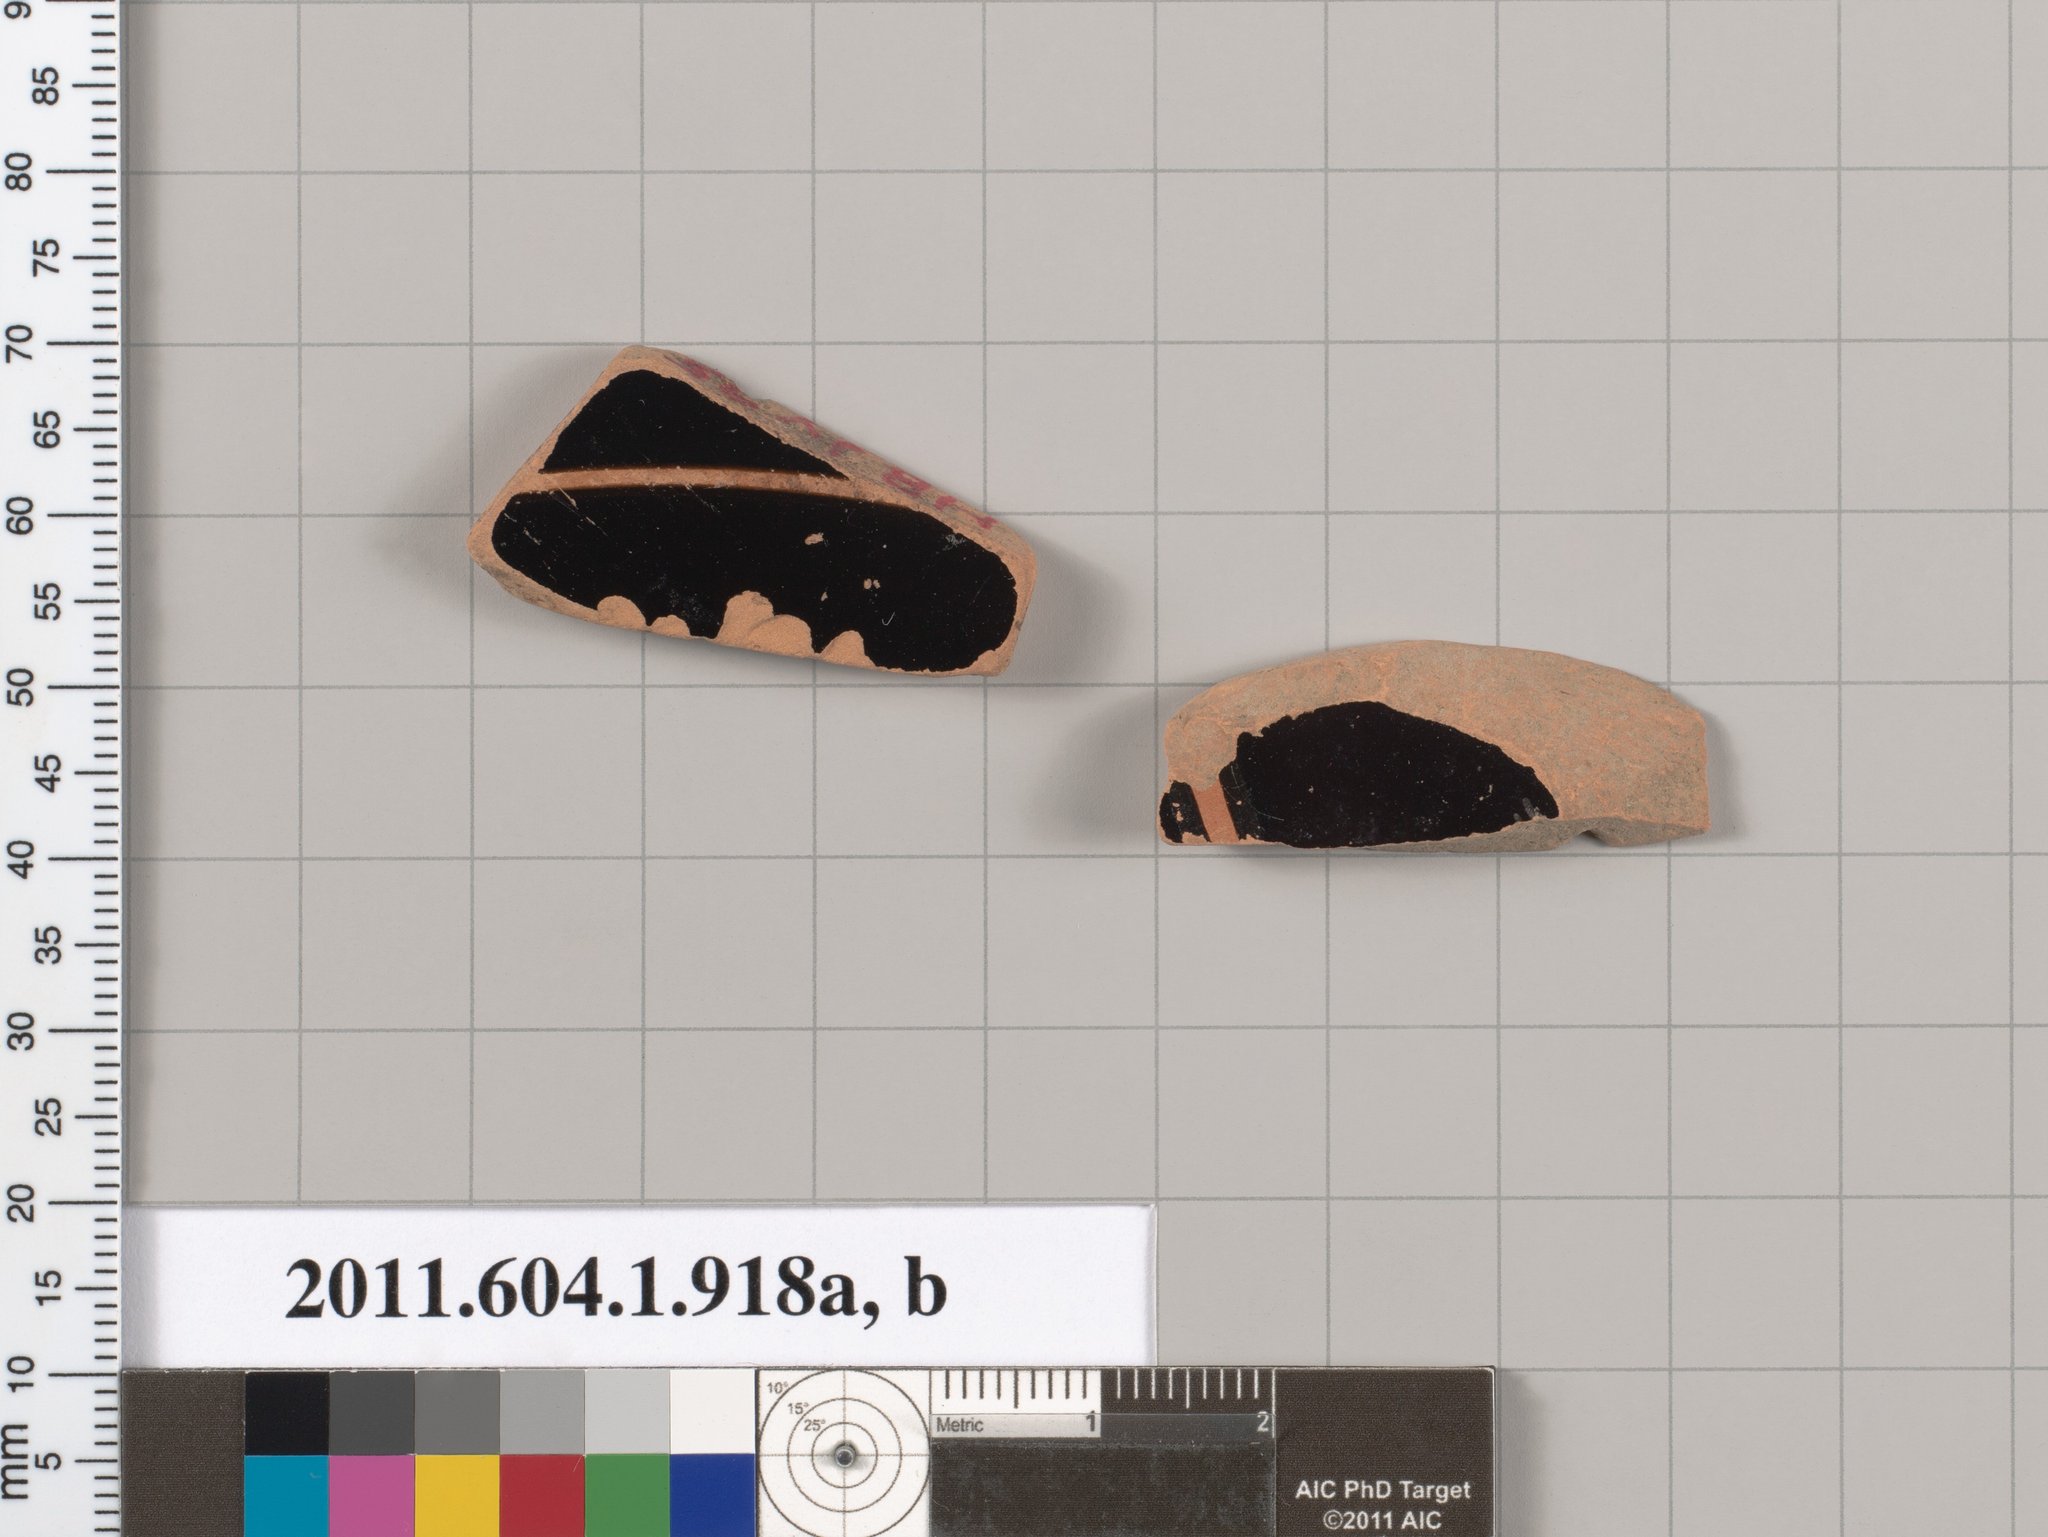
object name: kylix fragment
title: Terracotta fragments of kylikes (drinking cups)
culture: greek, attic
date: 500-401 BCE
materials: terracotta